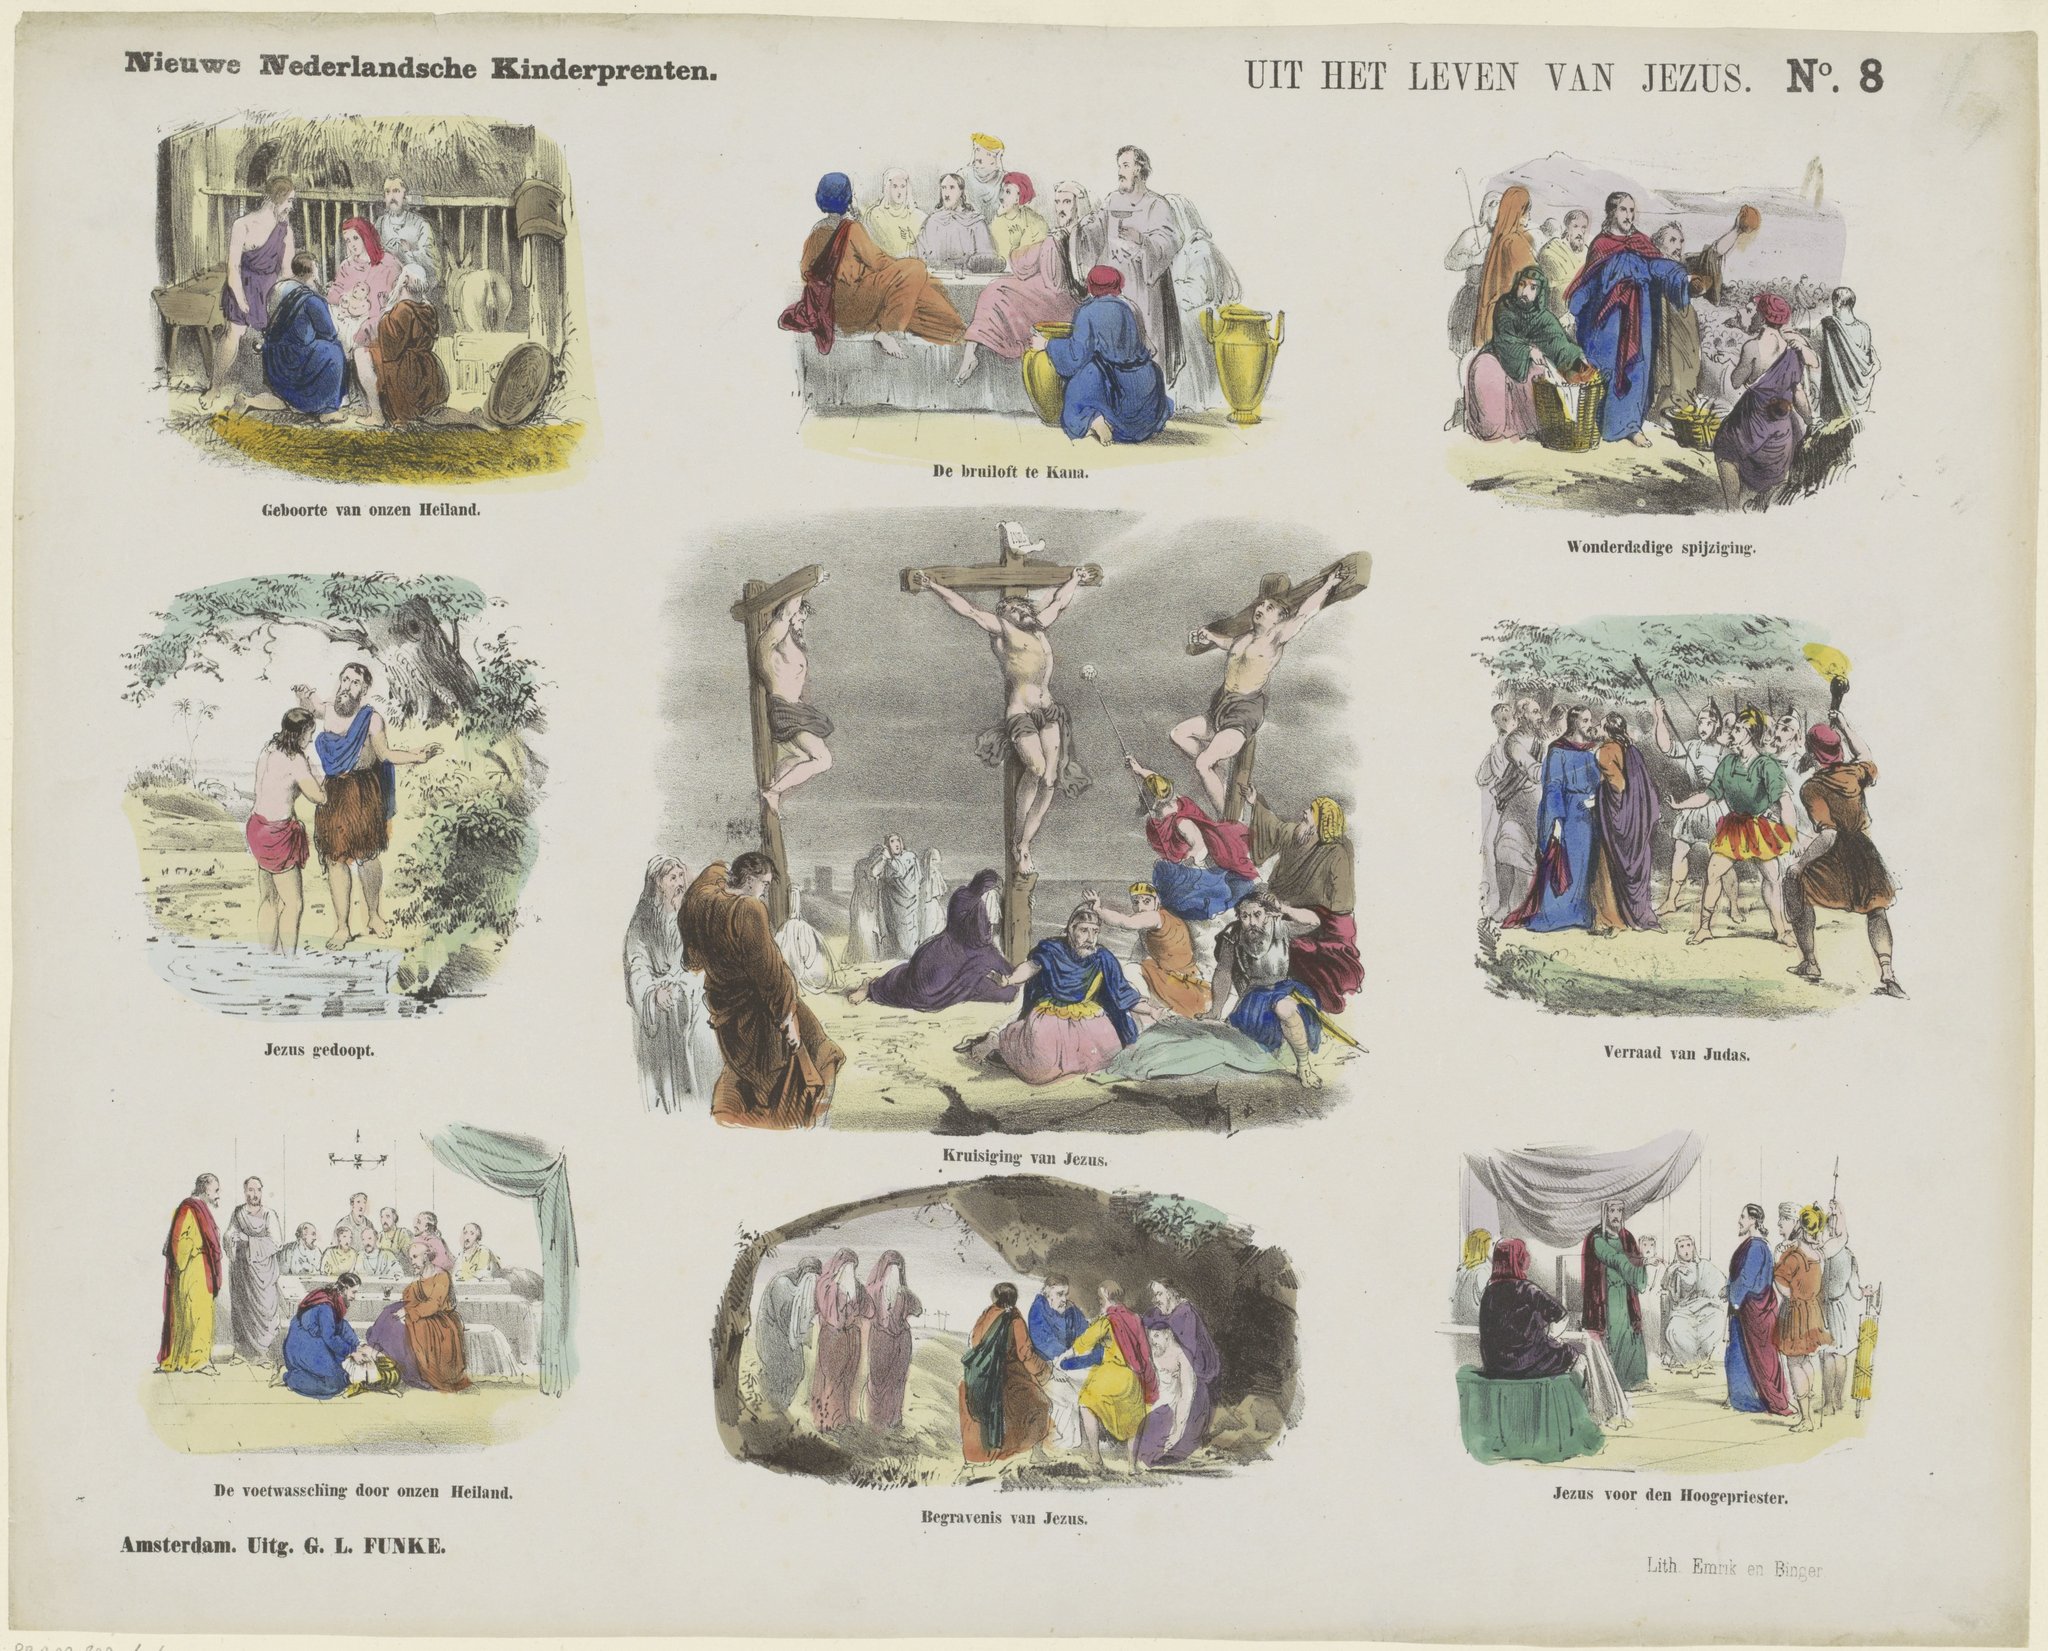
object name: print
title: Uit het leven van Jezus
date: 1865-1875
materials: paper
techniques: colour, letterpress printing, lithograph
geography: amsterdam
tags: series of scenes from the life of christ, passion of christ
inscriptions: collector's mark: Lugt 2760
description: Blad met 9 voorstellingen uit het leven van Christus, waaronder de geboorte, de bruiloft te Kana en de Kruisiging. Onder elke afbeelding een onderschrift. Genummerd rechtsboven: No. 8.